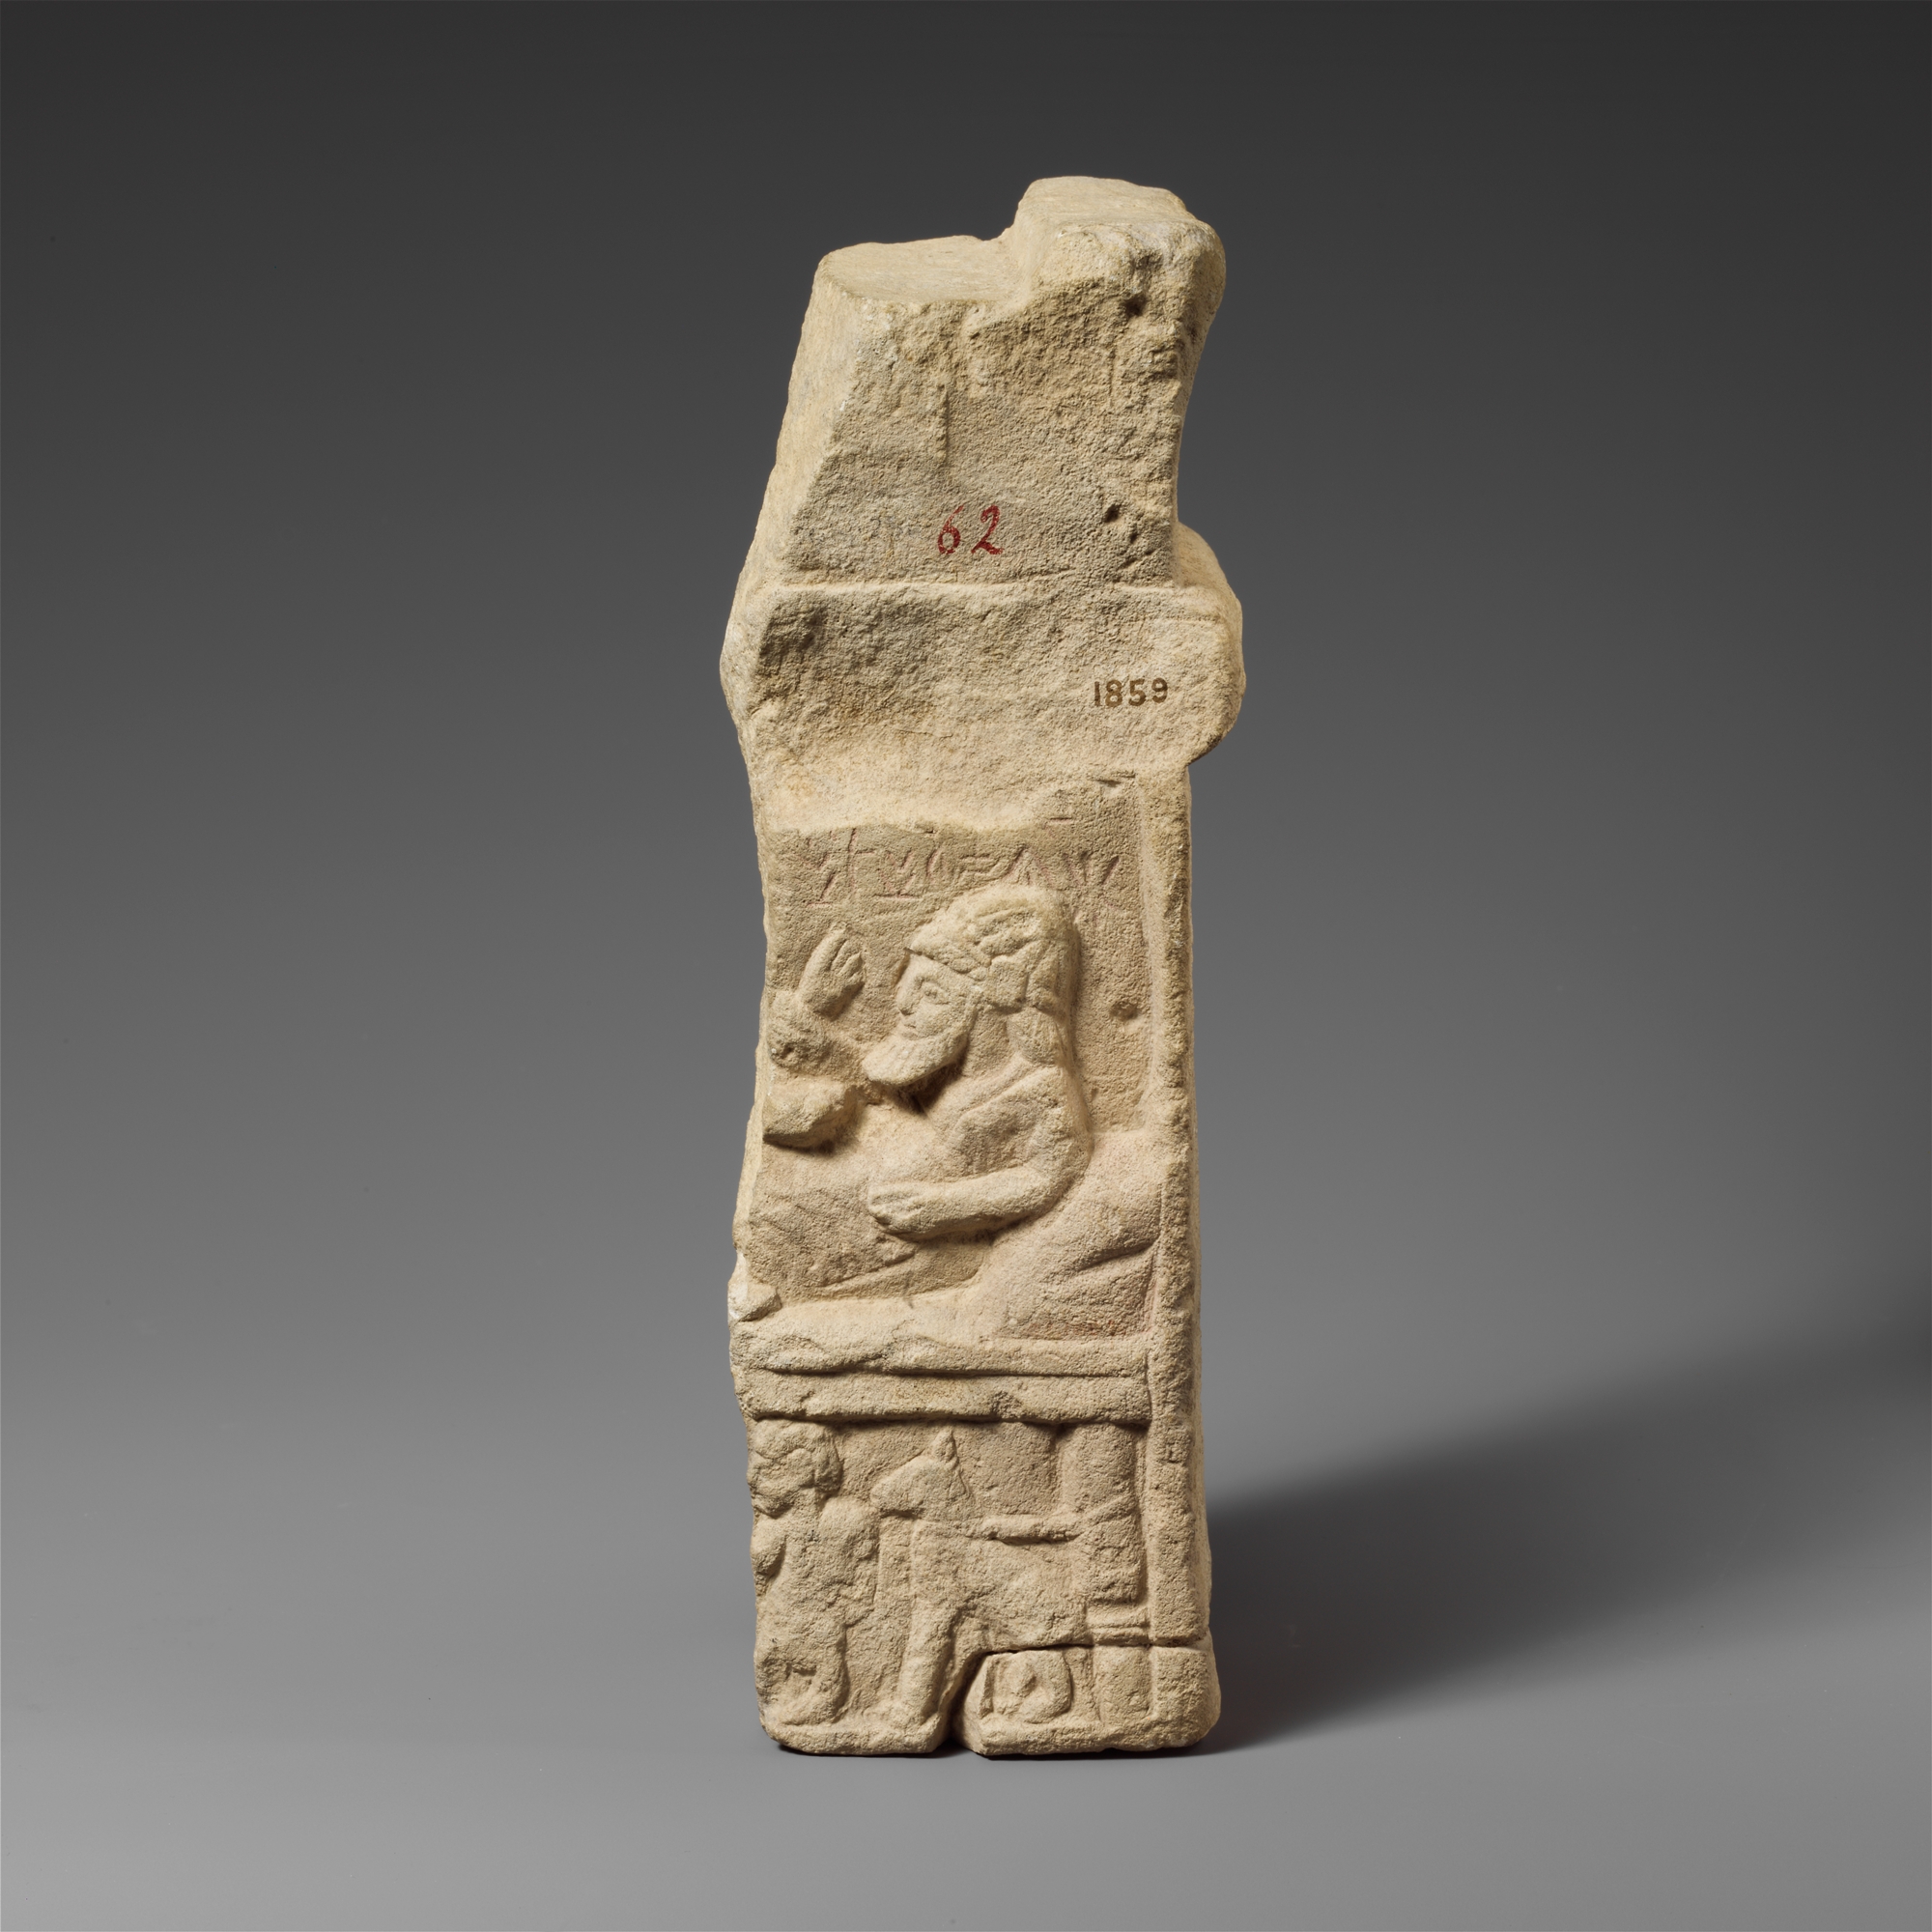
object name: altar, miniature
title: Limestone fragment of an altar with a relief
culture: cypriot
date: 500-468 BCE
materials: limestone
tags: men